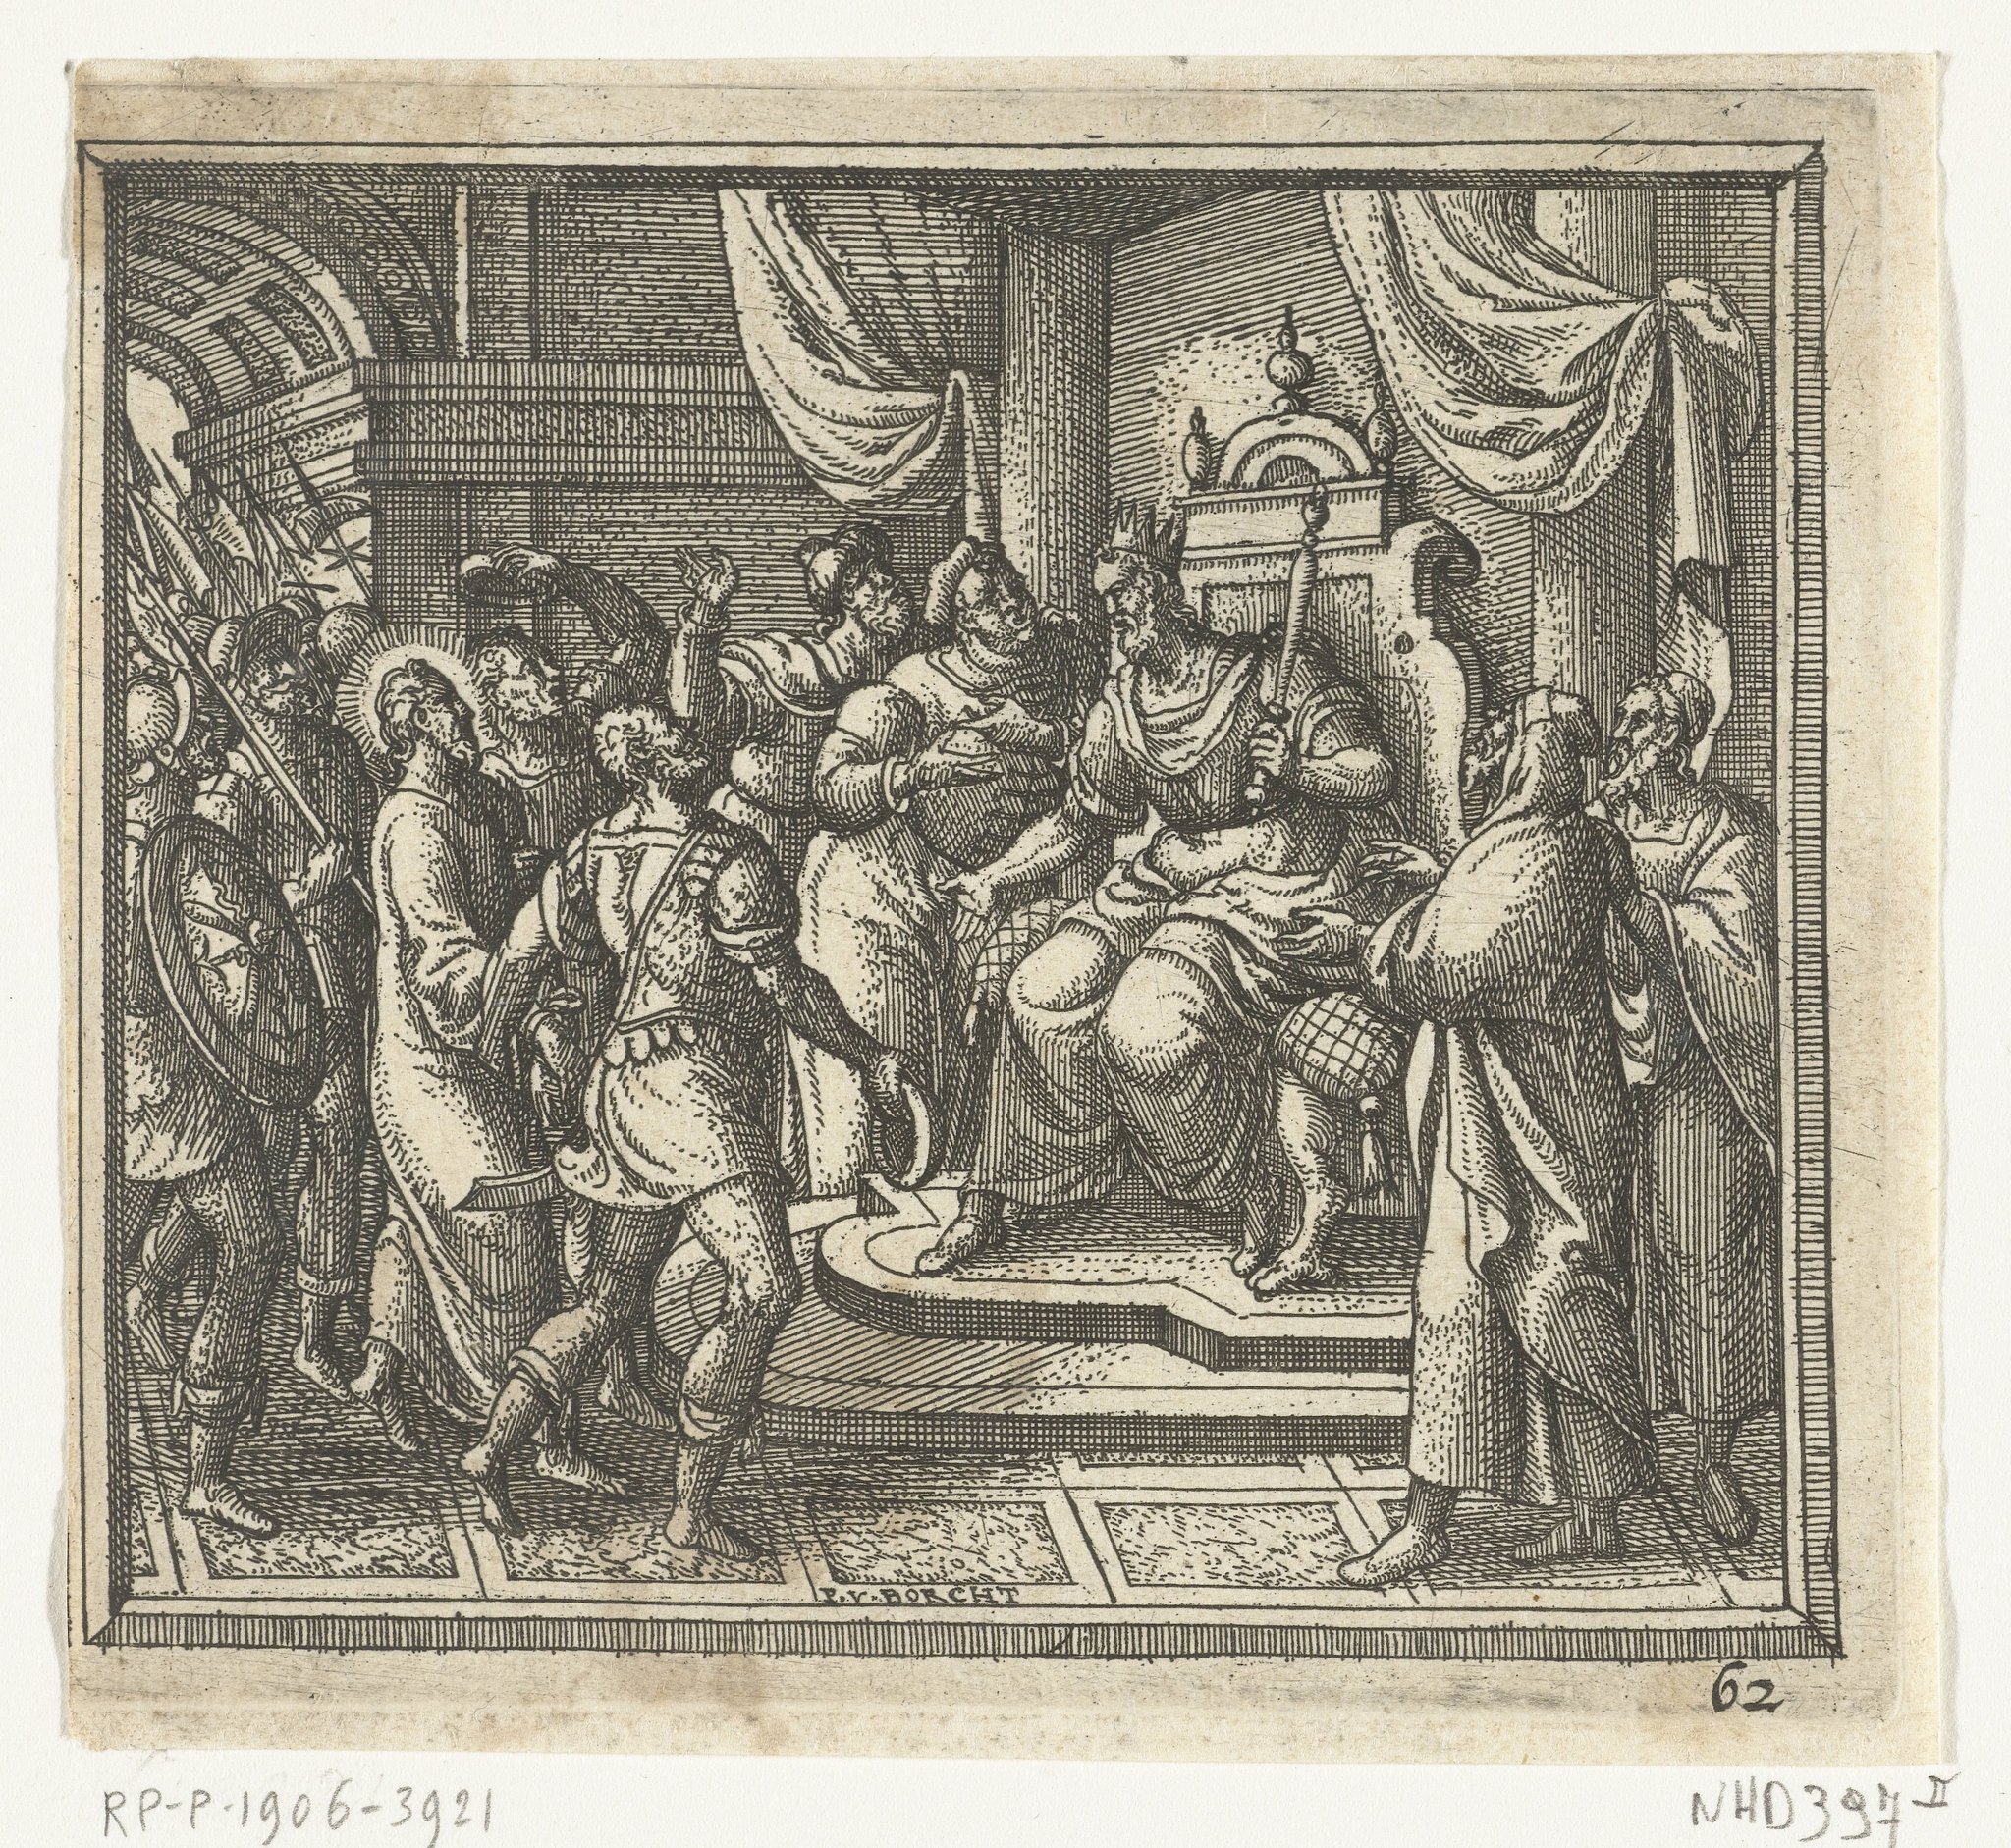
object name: print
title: Bijbelse taferelen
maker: pieter van der borcht (i)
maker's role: print maker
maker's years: 1545-1608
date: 1582-1592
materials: paper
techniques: etching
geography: antwerp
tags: christ before king herod; sometimes a gorgeous robe is brought (luke 23:8-11)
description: Mogelijk uit een editie van Renatus Christianus, 'Bibelsche Figuren' (eerste editie Leiden 1592).. Alleen rechterdeel van de prent is aanwezig